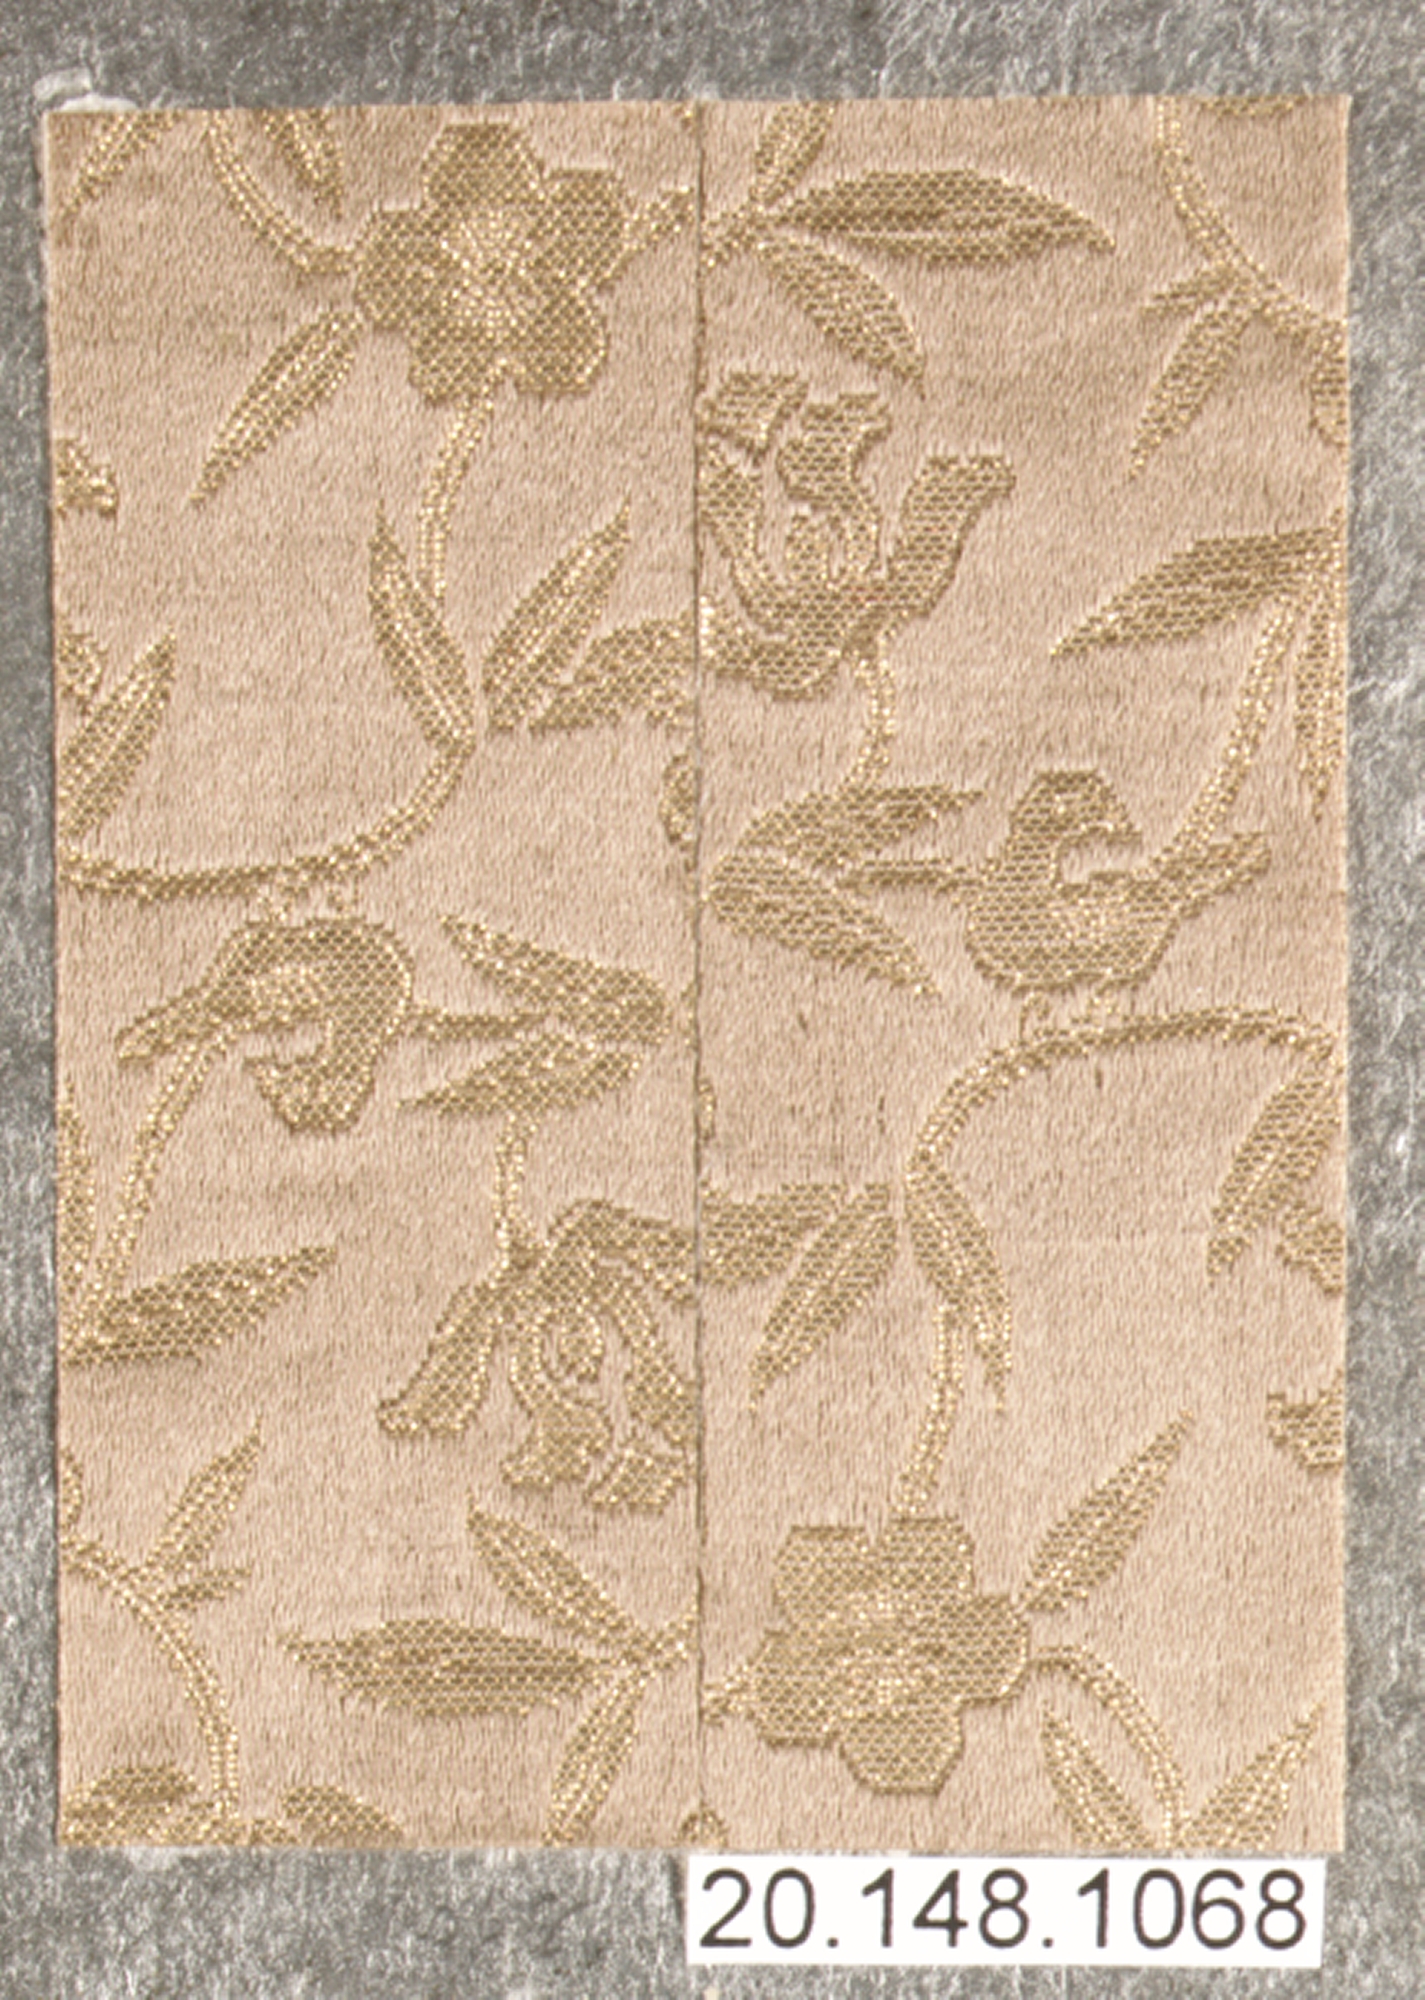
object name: piece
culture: china or japan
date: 1701-1800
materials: silk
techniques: compound weave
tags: birds,flowers,leaves